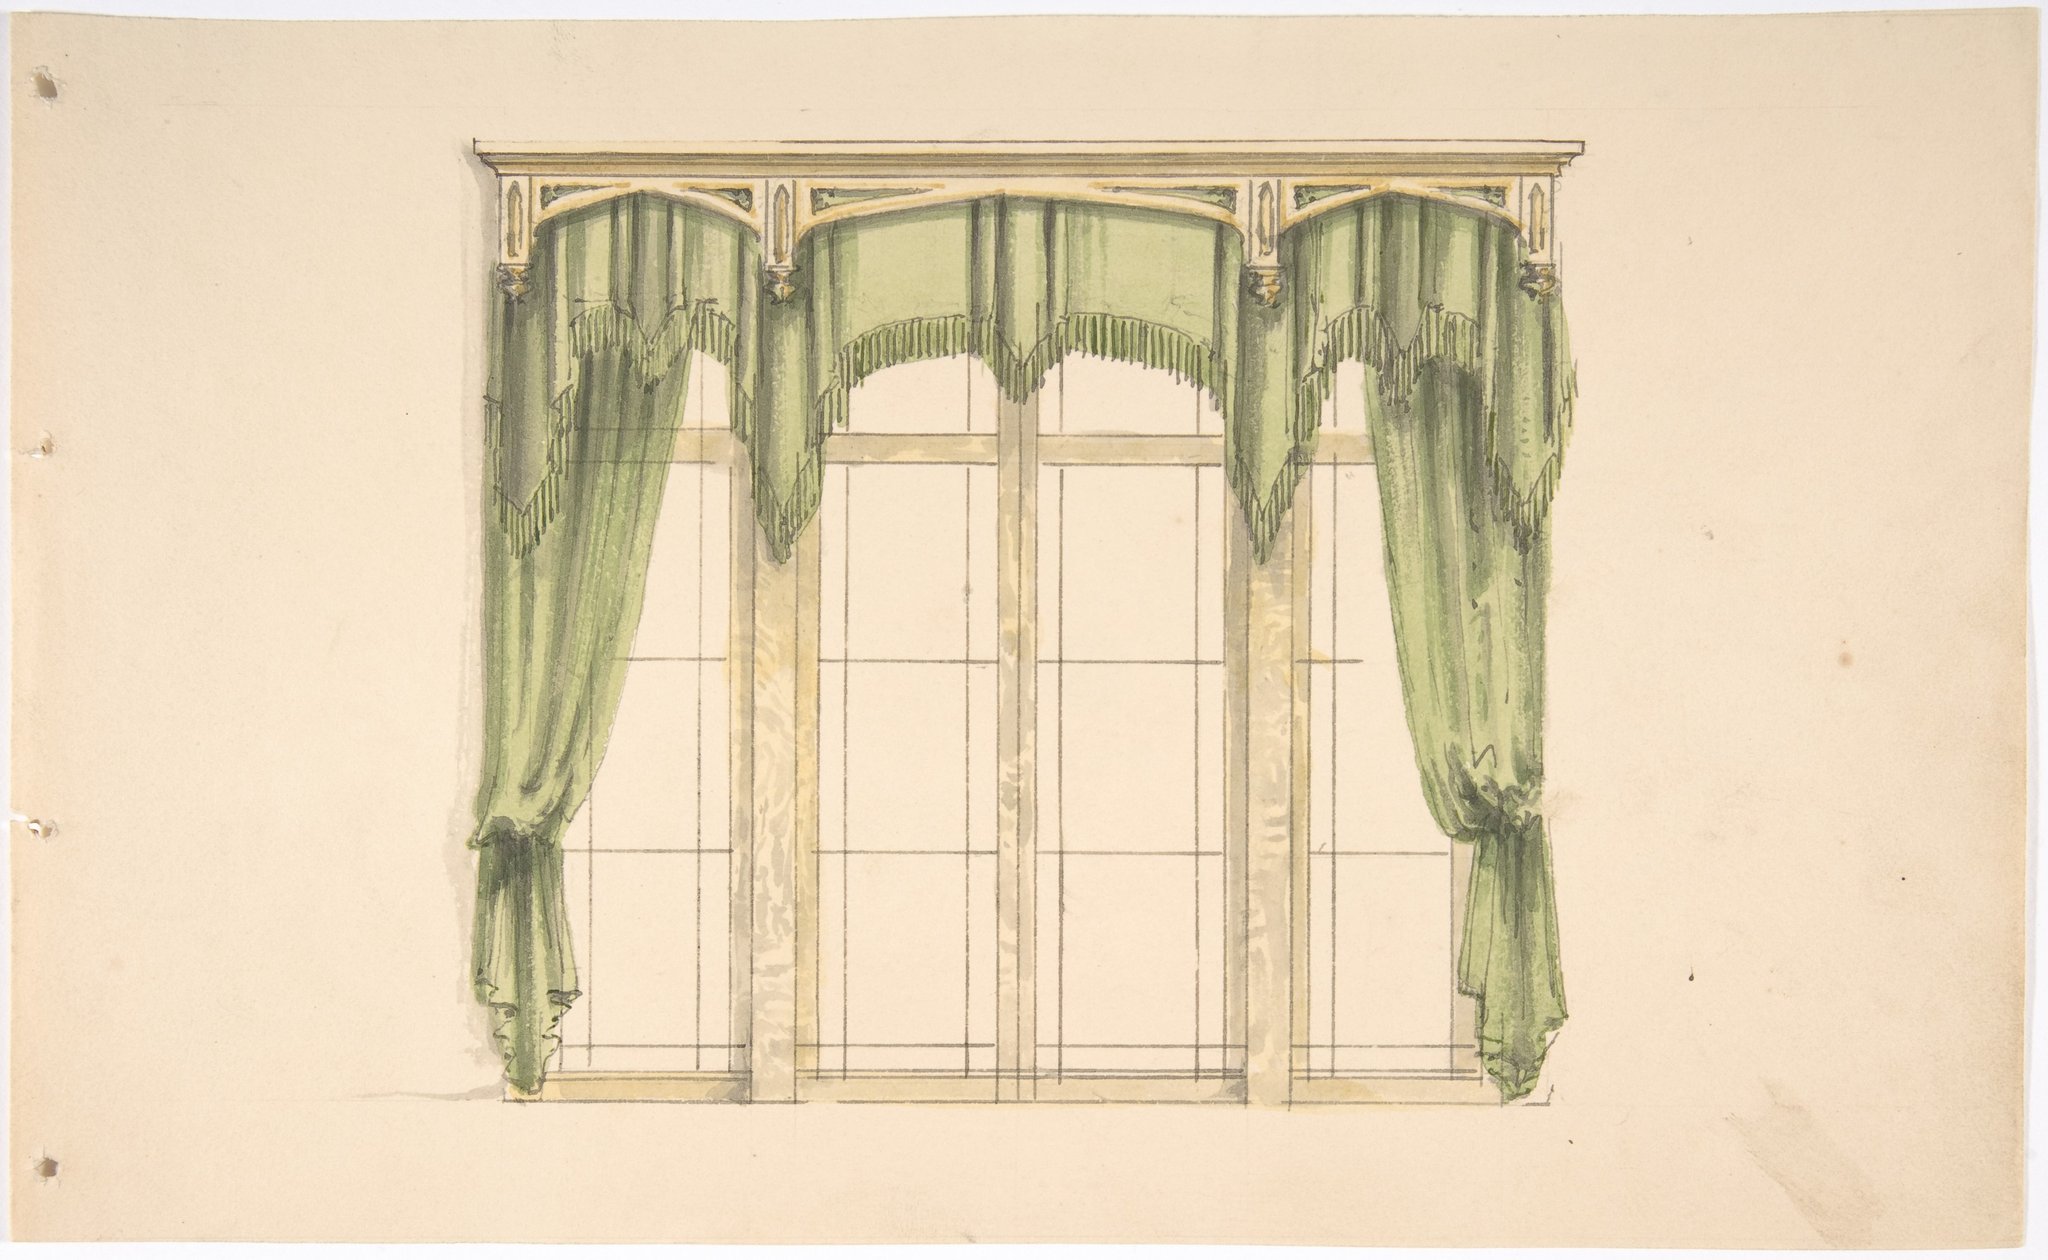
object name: drawing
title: Design for Green Curtains with Green Fringes and a Gold Pediment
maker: anonymous, british, 19th century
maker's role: artist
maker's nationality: british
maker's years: 1800-1900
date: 1801-1833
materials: ink, watercolor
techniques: brush, pen, wash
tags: curtains